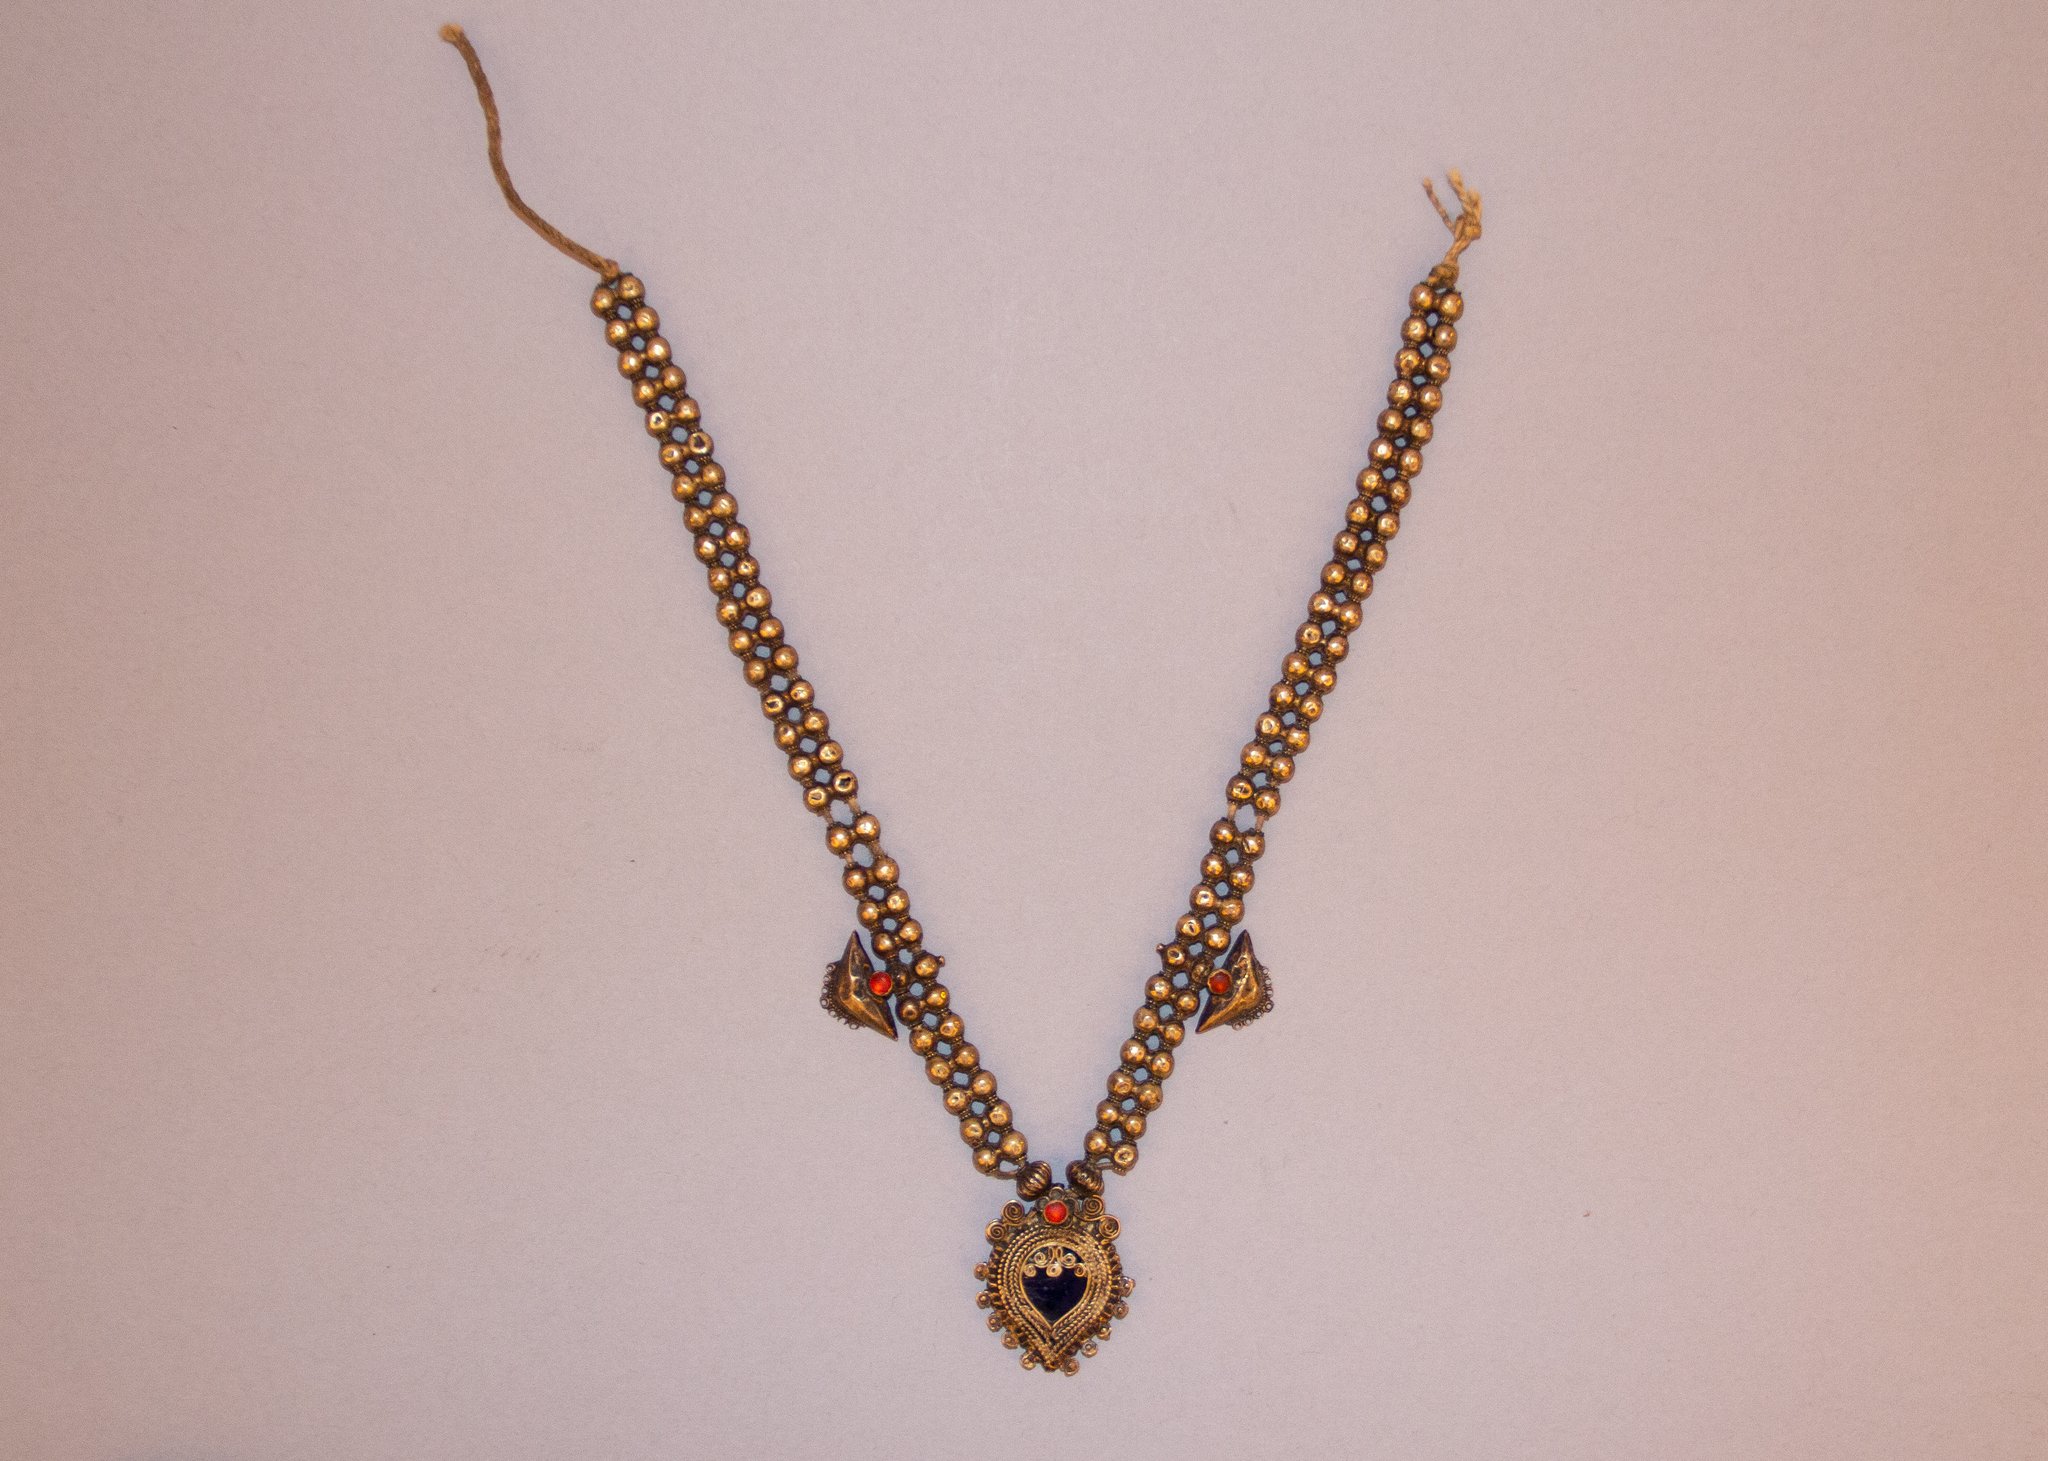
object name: necklace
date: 1601-1900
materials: gold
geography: india